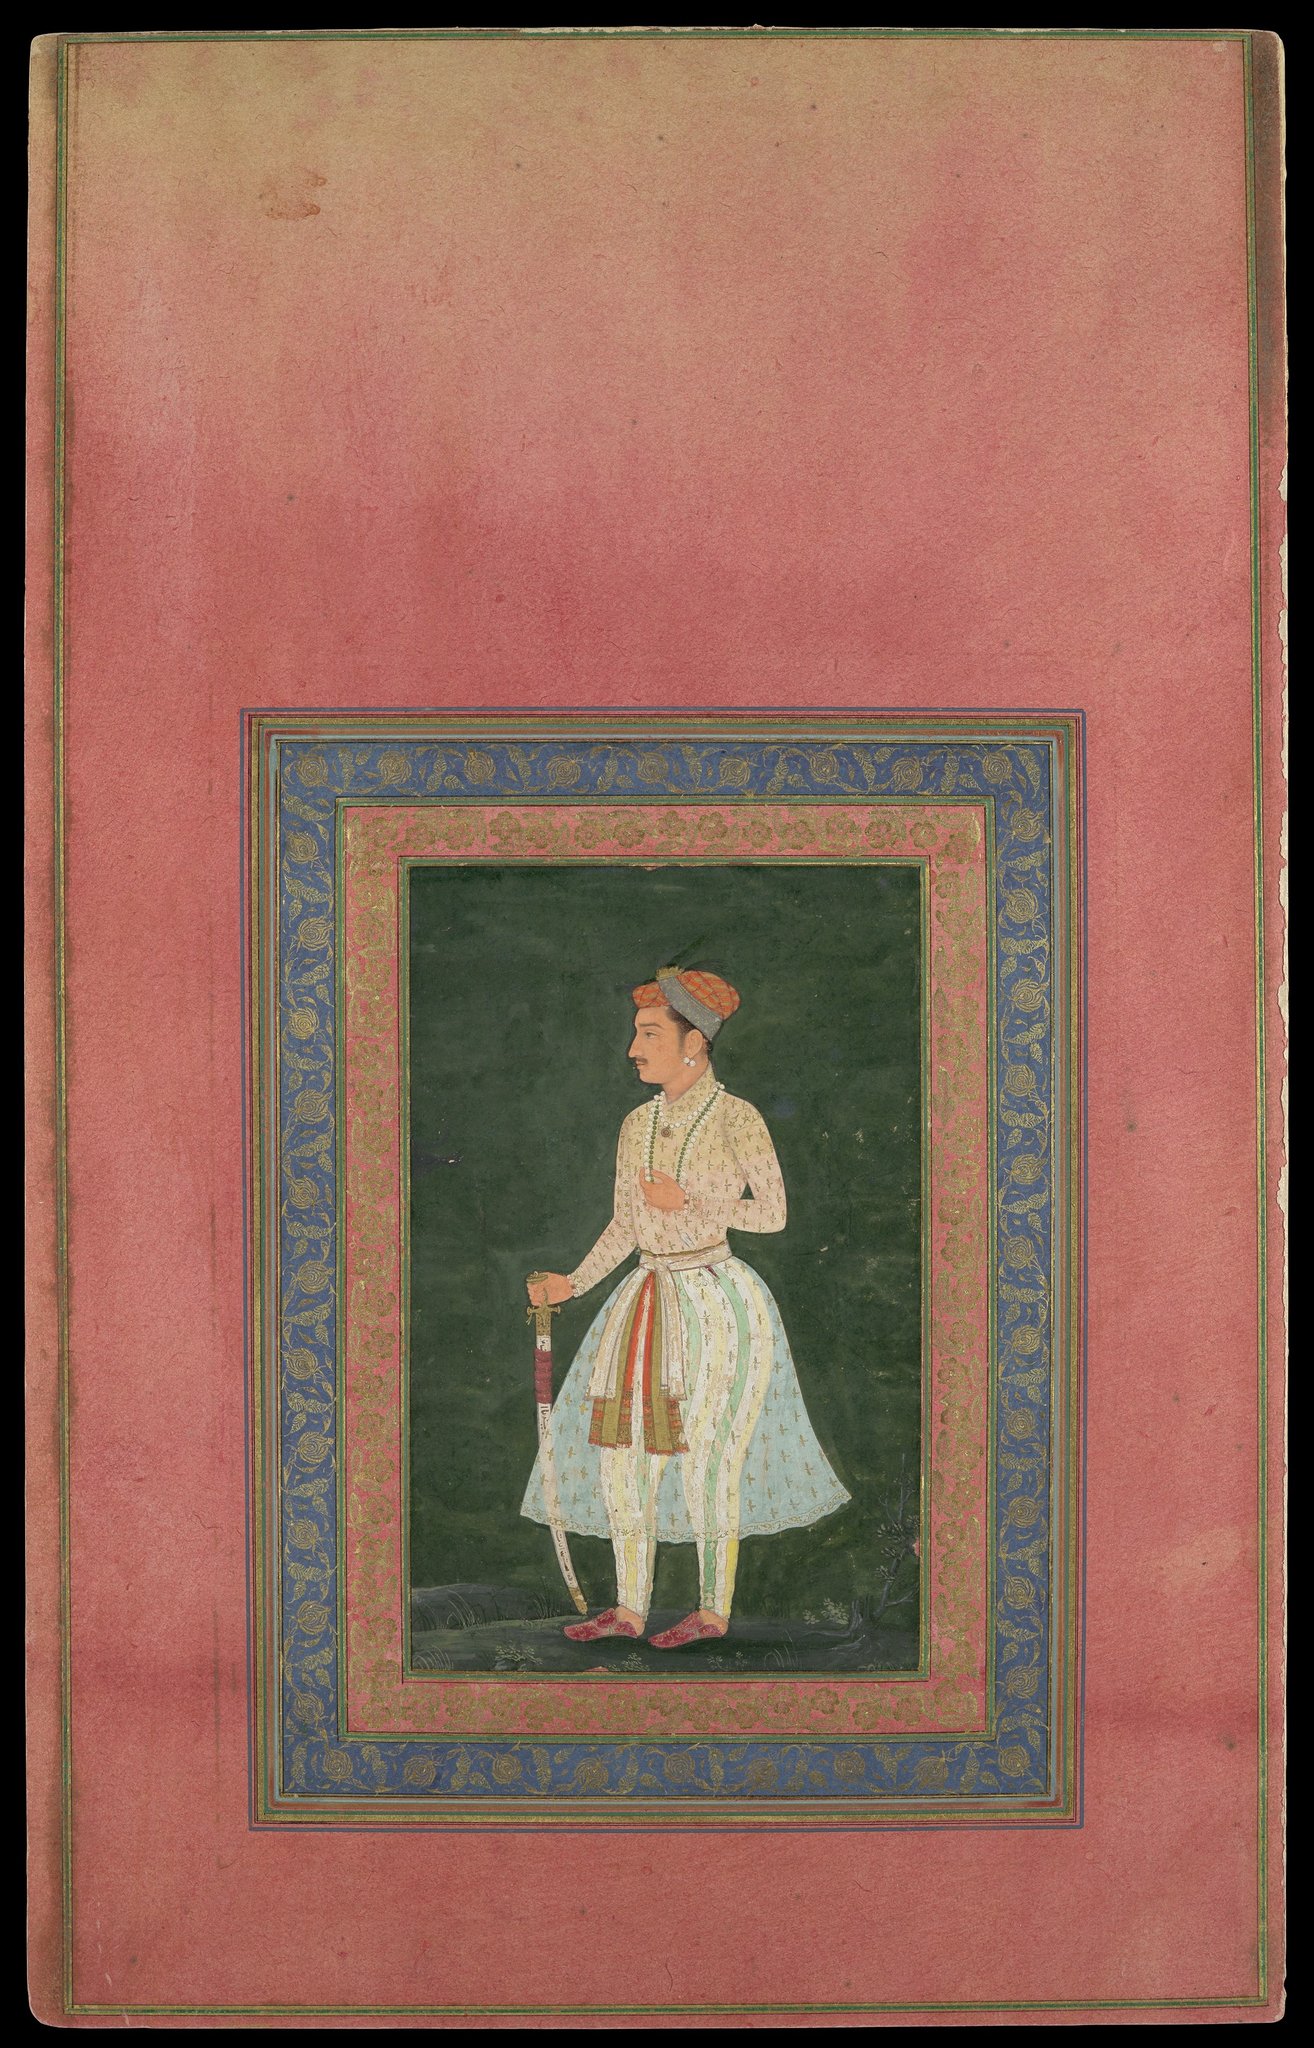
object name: illustrated album leaf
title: "Portrait of a Noble in Gauzy White Costume", Folio from the Davis Album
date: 1667-1700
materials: gold, ink, paper, watercolor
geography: india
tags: swords,men,profiles